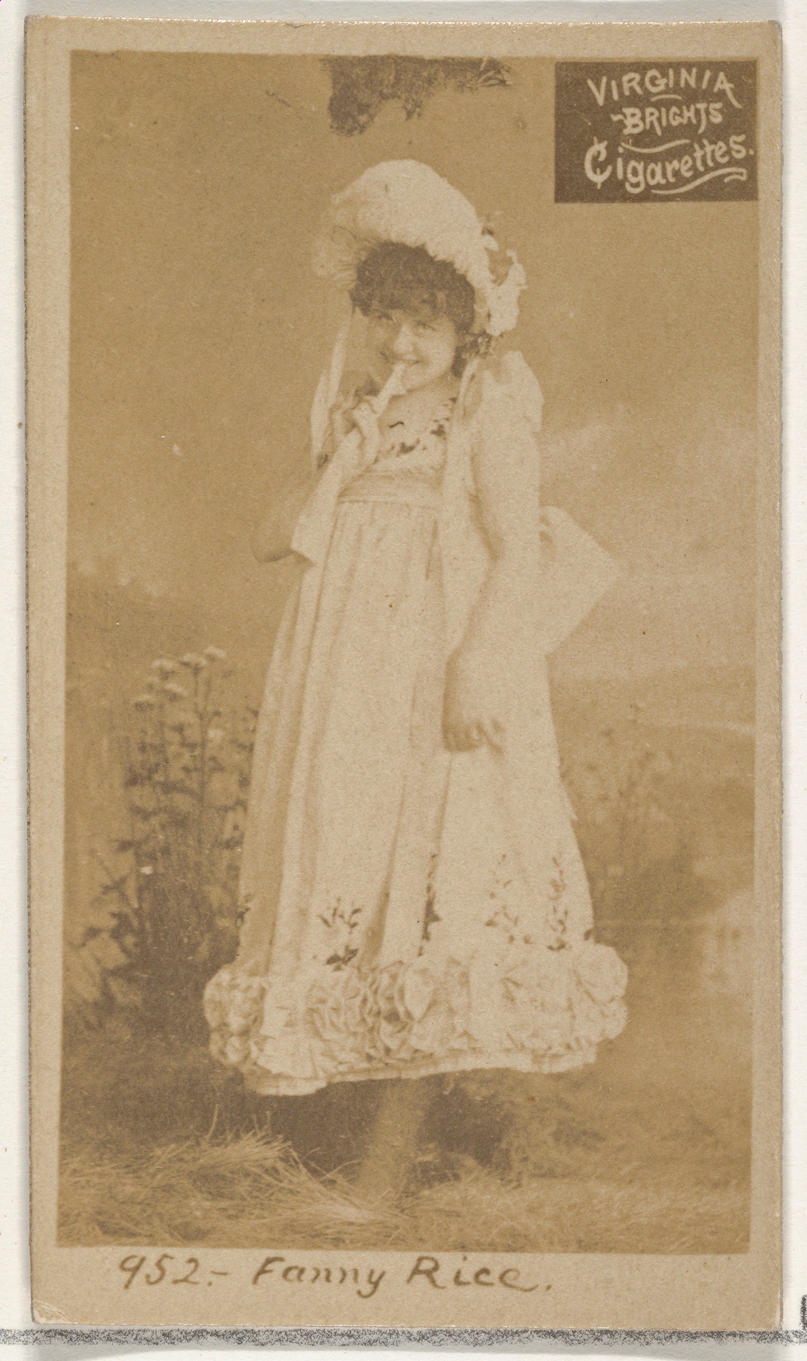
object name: photograph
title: Card 952, Fanny Rice, from the Actors and Actresses series (N45, Type 2) for Virginia Brights Cigarettes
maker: allen & ginter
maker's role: publisher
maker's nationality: american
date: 1888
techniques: albumen silver print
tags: portraits,women,actresses